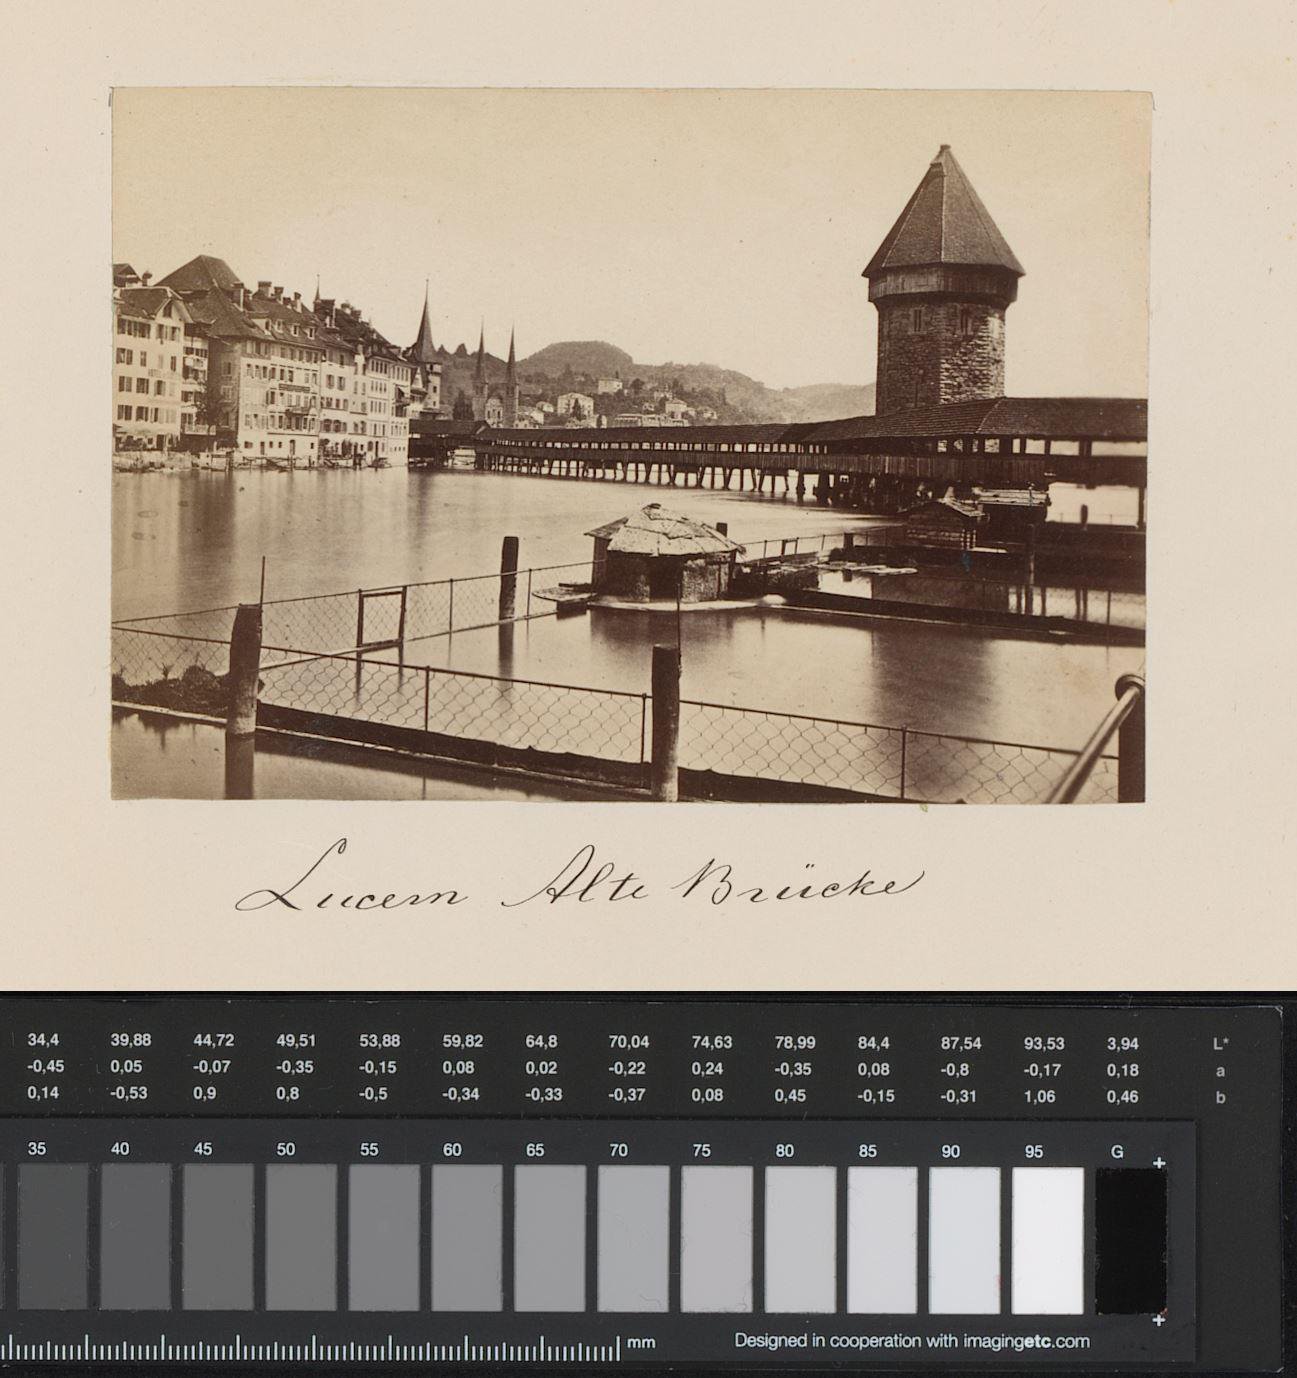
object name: album leaf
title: Gezicht op de Kapelbrug te Luzern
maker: Anonymous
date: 1860-1900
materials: photographic support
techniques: albumen print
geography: lucerne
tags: city-view in general; 'veduta', bridge in city across river, canal, etc.